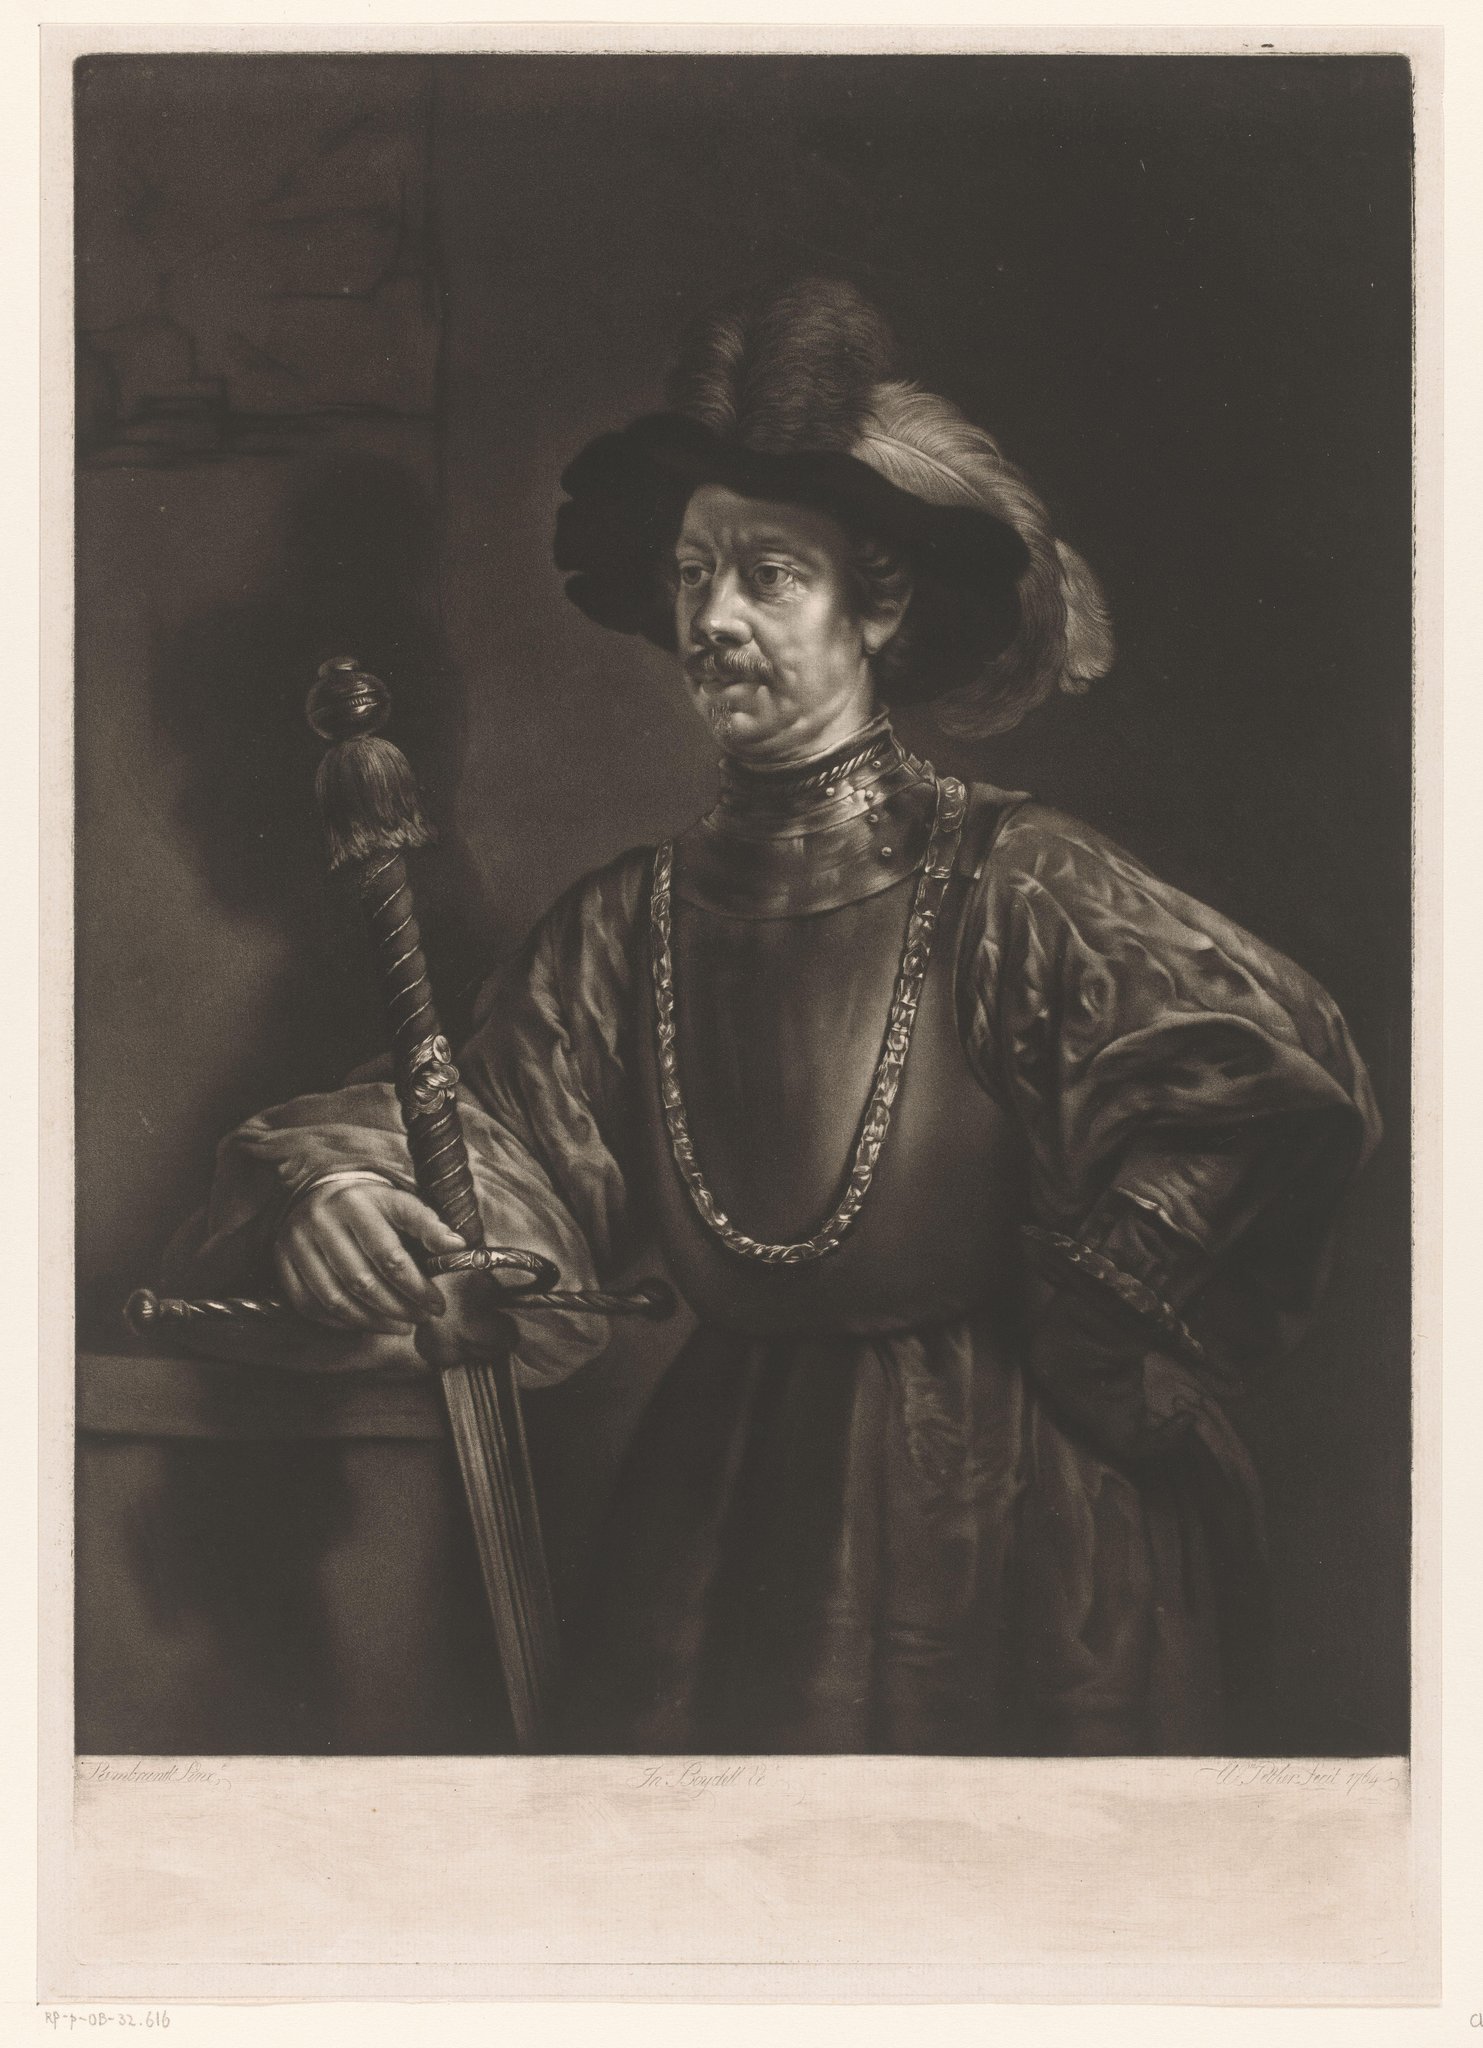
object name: print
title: Portret van een onbekende officier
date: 1750-1804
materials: paper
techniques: mezzotint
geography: london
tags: historical persons, officer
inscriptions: collector's mark: Lugt 240